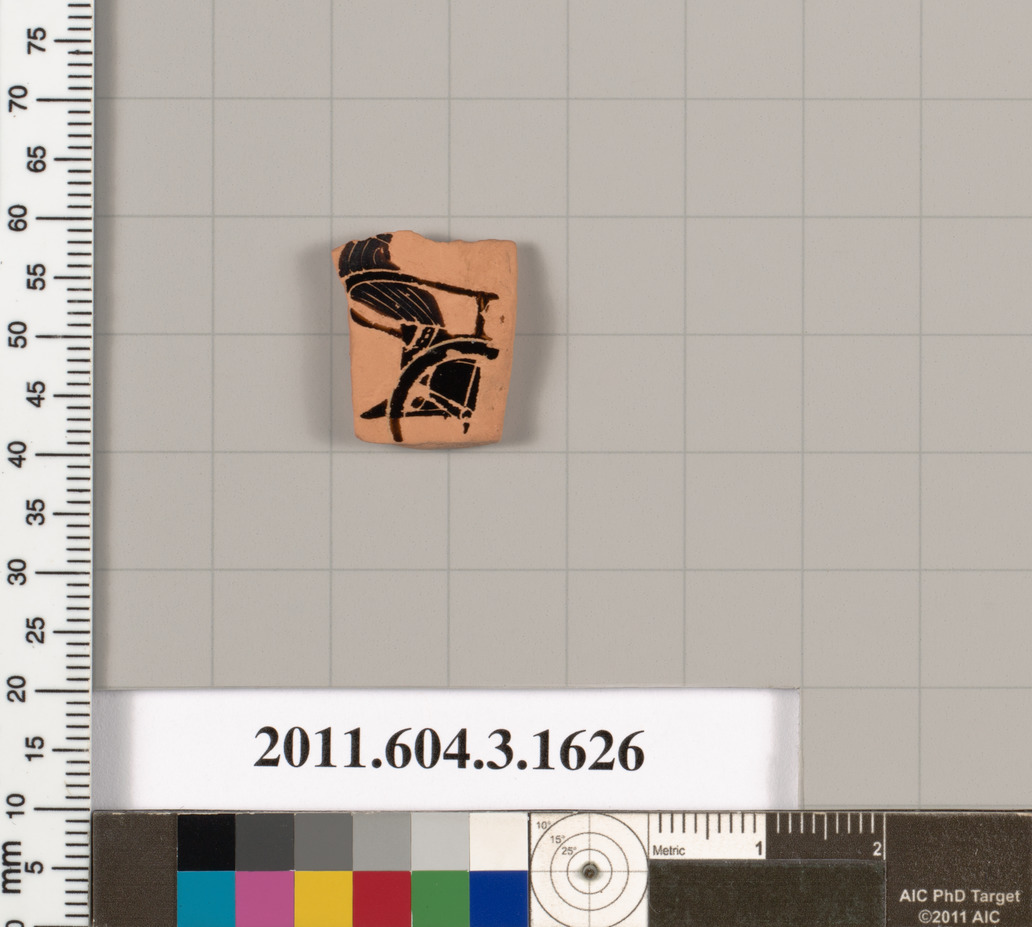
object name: kylix fragment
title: Terracotta fragment of a kylix: Band cup (drinking cup)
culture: greek, attic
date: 560-550 BCE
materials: terracotta